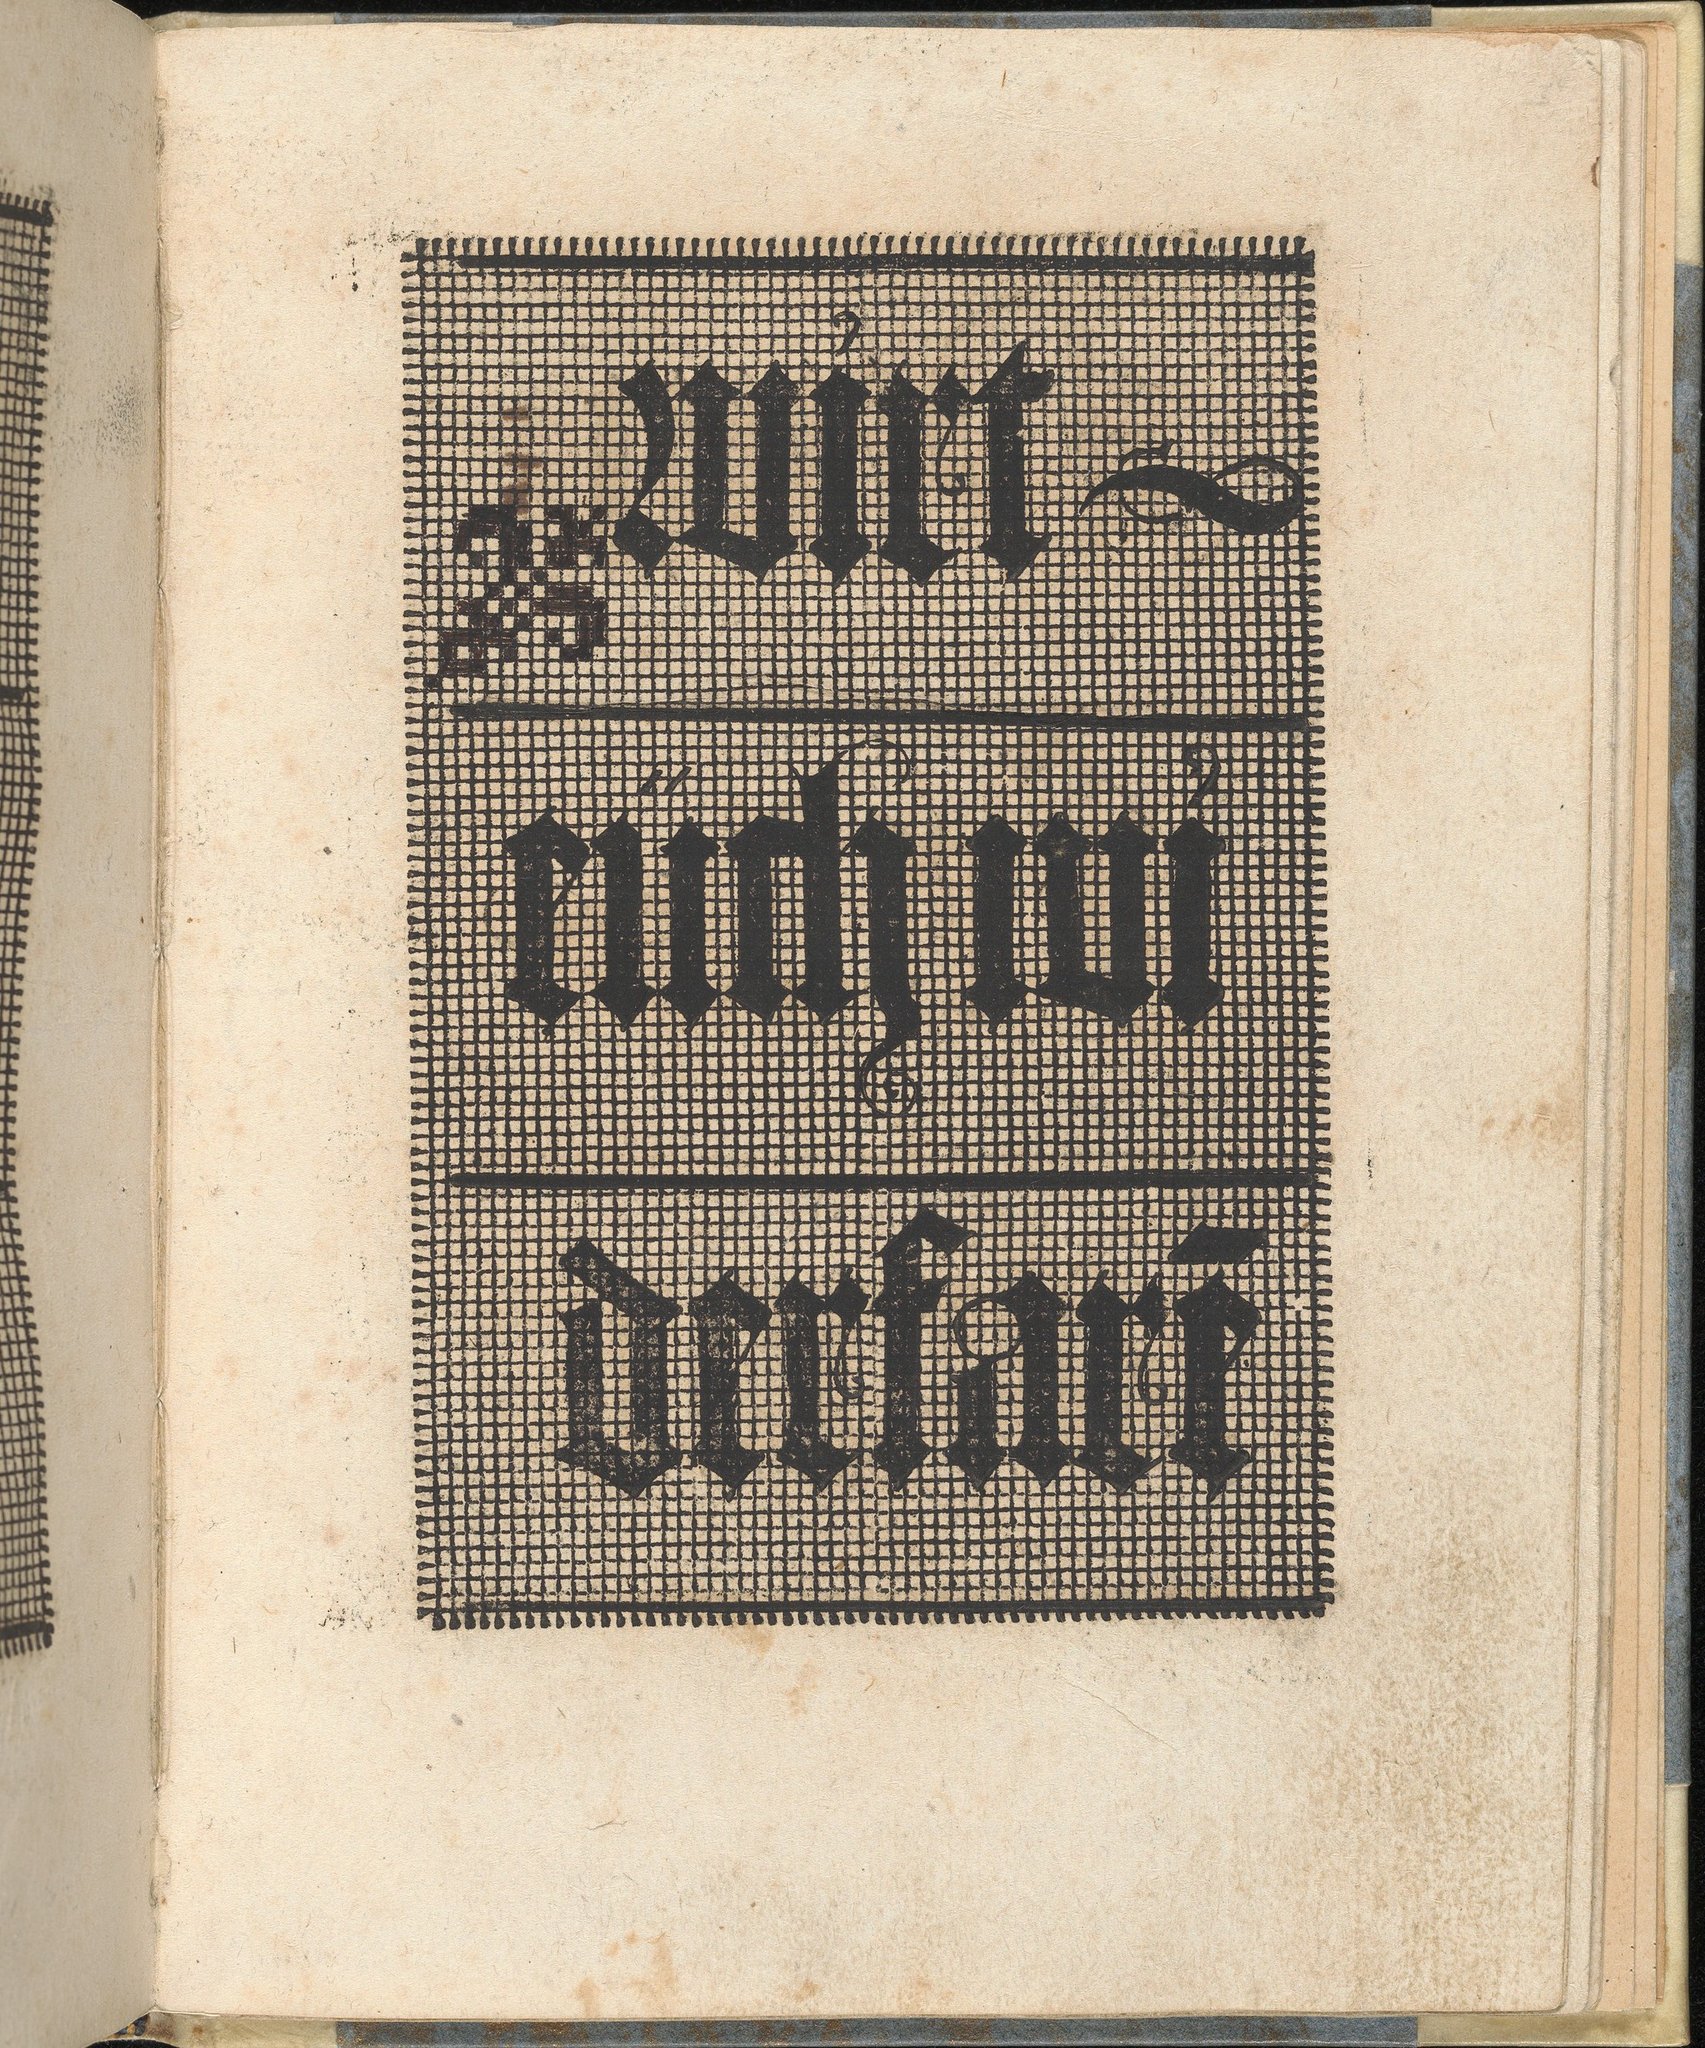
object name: book print ornament architecture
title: Ein ney Furmbüchlein, Page 5, recto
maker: johann schönsperger the younger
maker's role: publisher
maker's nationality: german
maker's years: 1490-1550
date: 1525-1529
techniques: woodcut